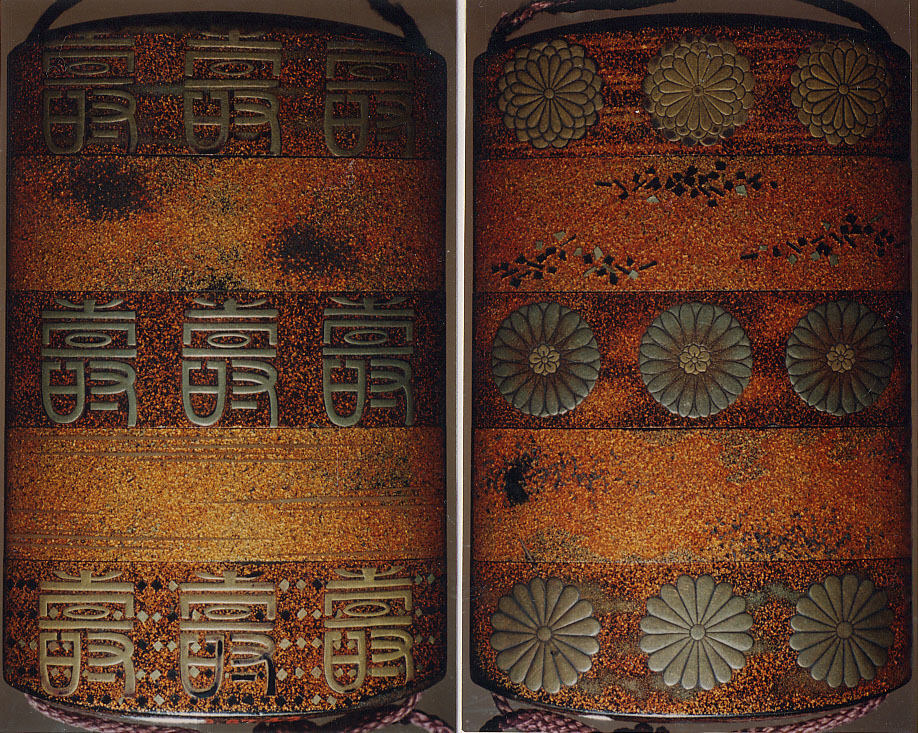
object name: inrō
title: Case (Inrō) with Design of Chrysanthemums (obverse); Chinese Characters for Long Life (reverse)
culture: japanese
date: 1801-1900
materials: gold, lacquer, silver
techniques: fundame, hiramakie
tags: flowers